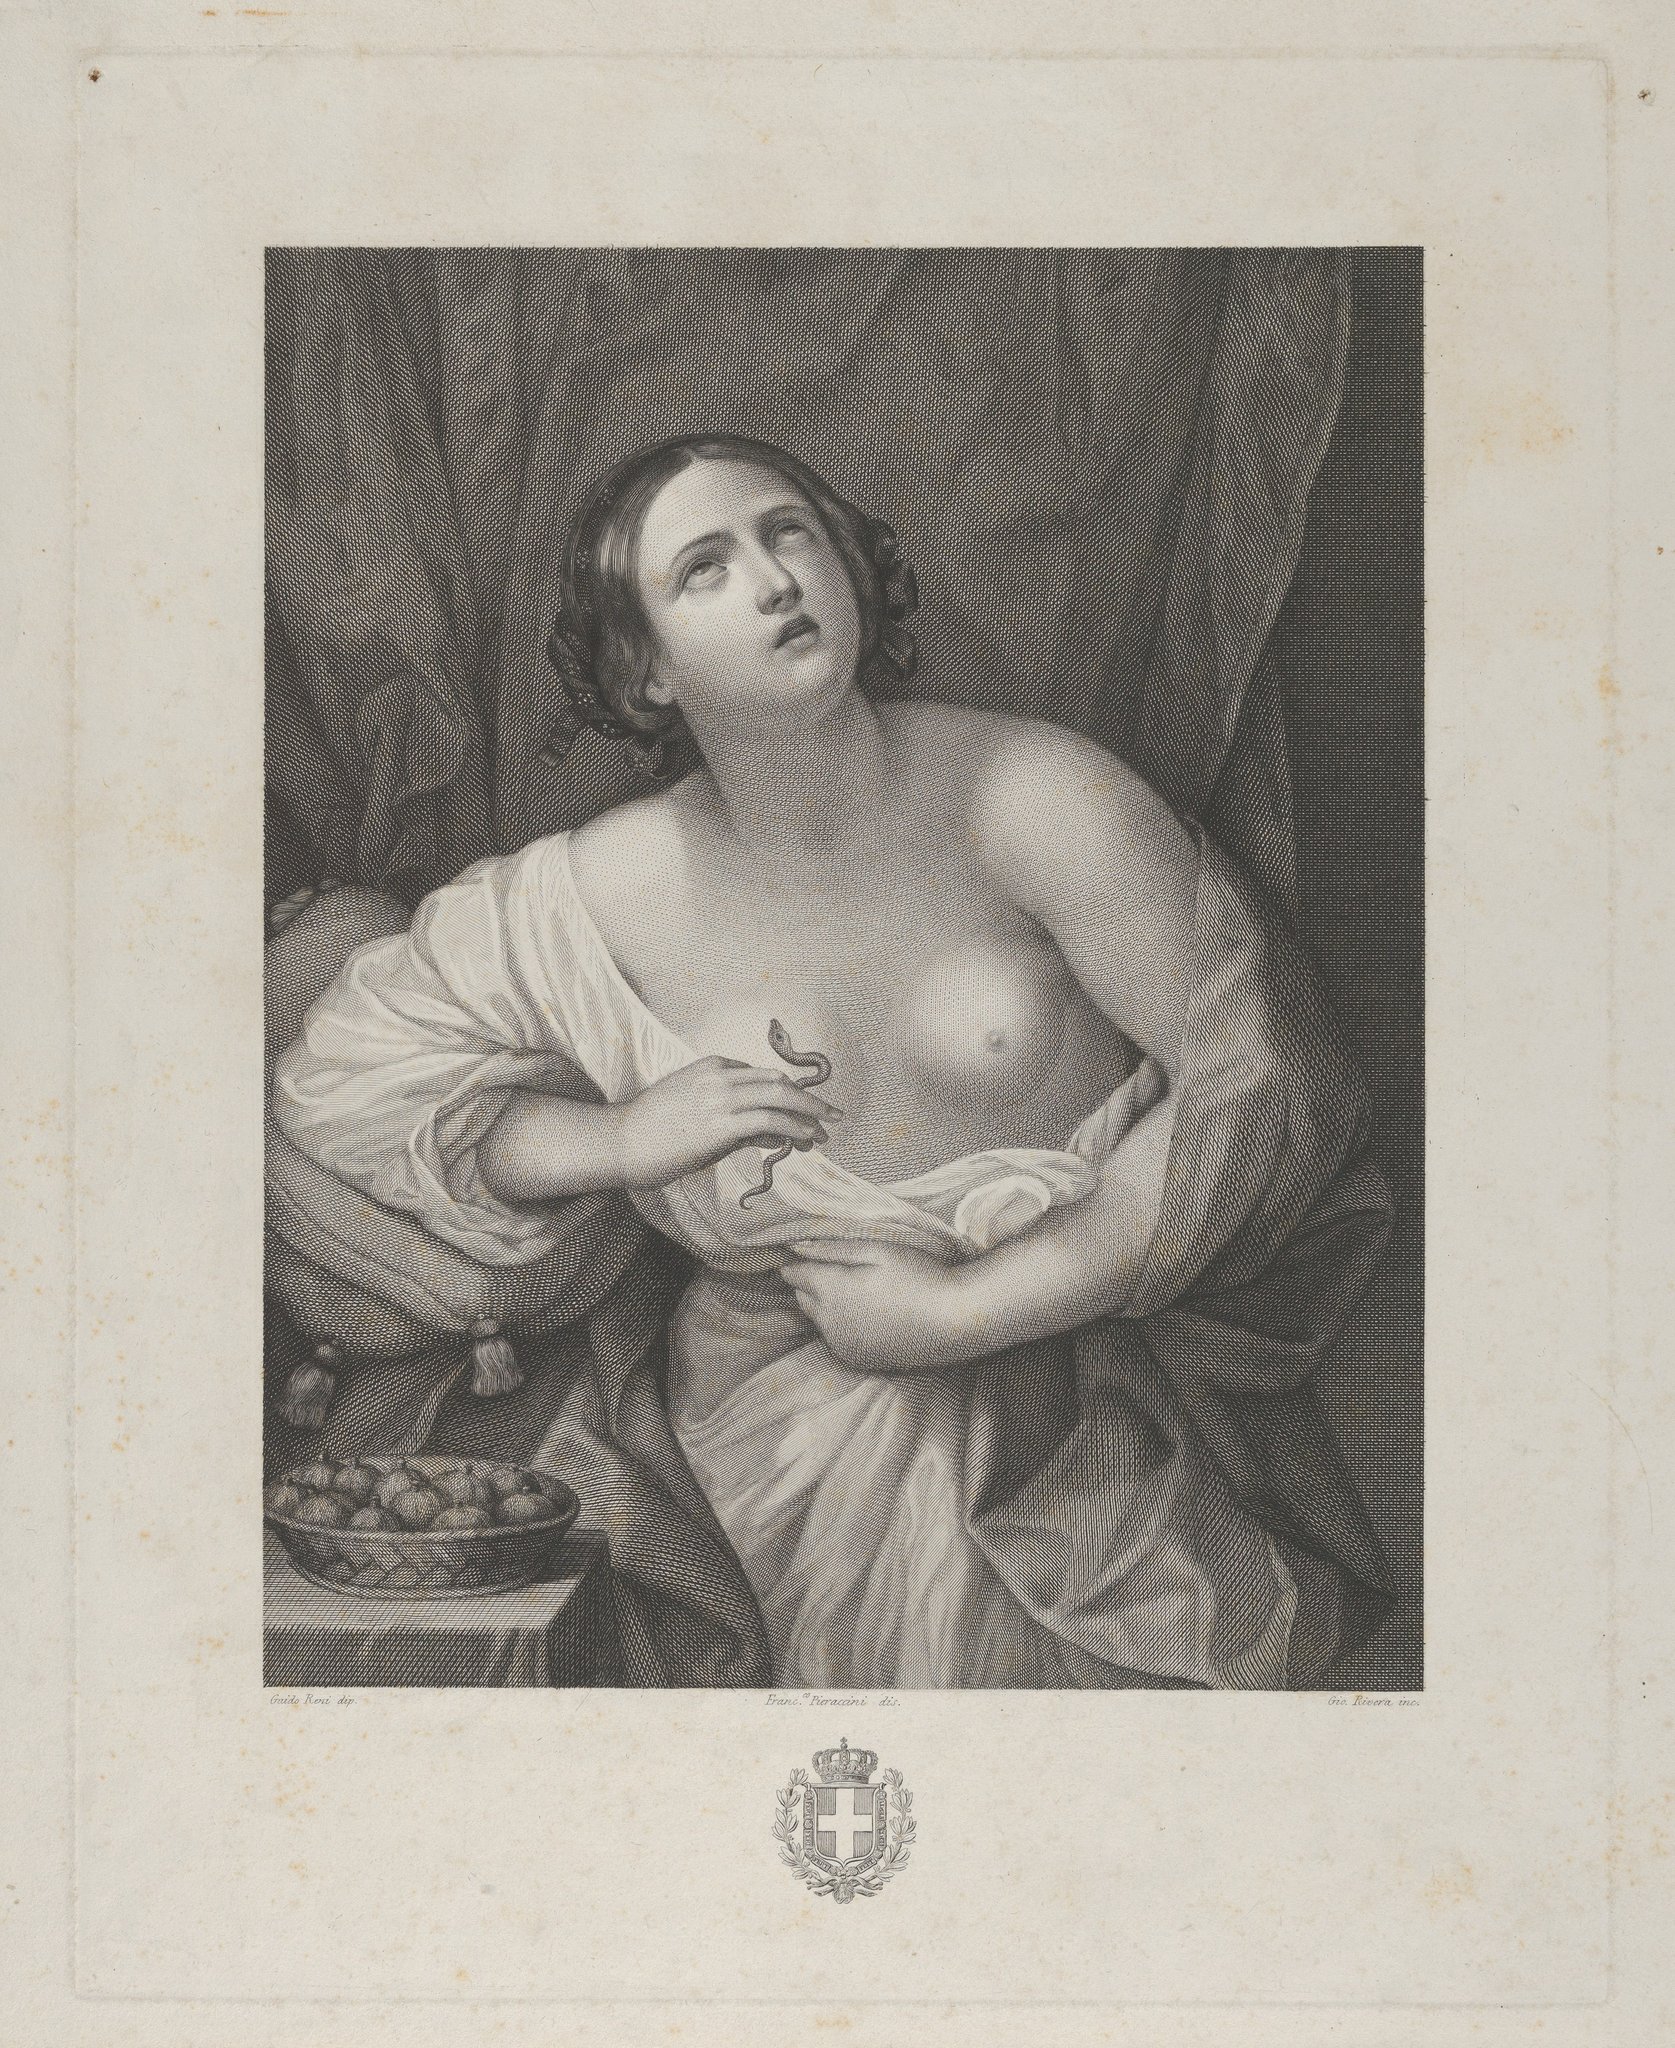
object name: print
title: Cleopatra looking upwards while holding an asp in her right hand and clutching at her stomach with her left, a bowl of figs at left, after Reni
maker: giovanni rivera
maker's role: artist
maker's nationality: italian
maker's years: 1771-1861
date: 1796-1861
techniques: engraving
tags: cleopatra,portraits,snakes,coat of arms